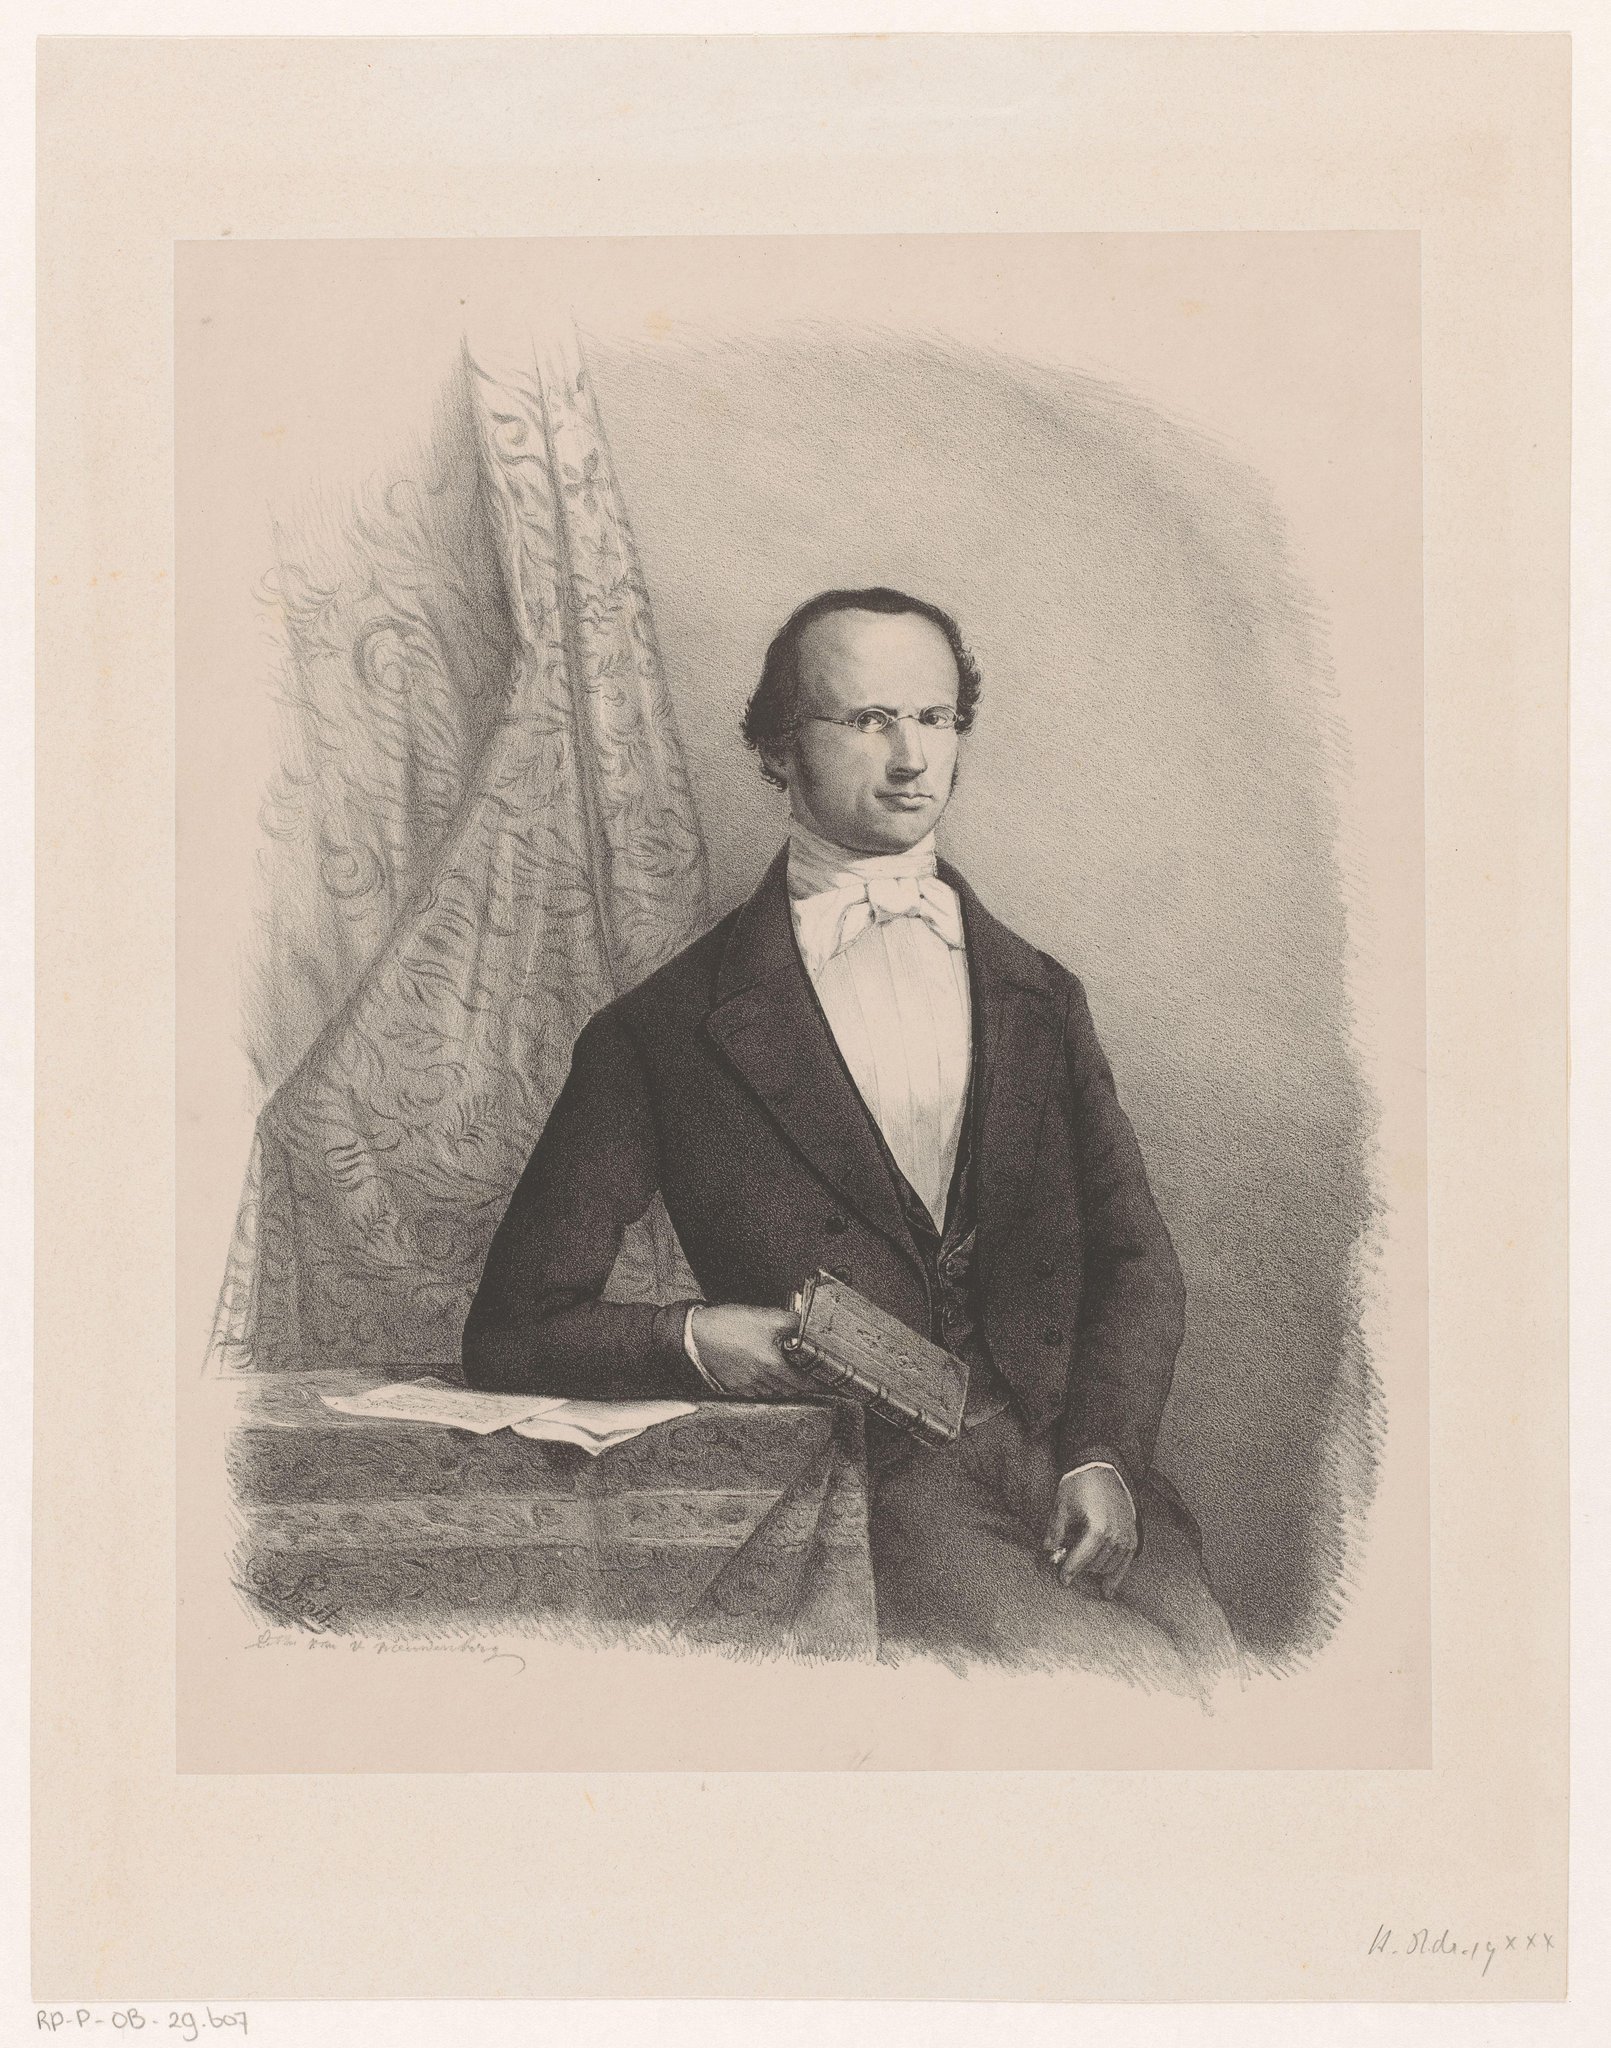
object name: print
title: Portret van Antonie Niermeijer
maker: johannes smit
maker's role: print maker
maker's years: 1805-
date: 1855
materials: paper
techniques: lithograph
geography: netherlands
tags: leiden, historical persons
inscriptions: collector's mark: Lugt 2228